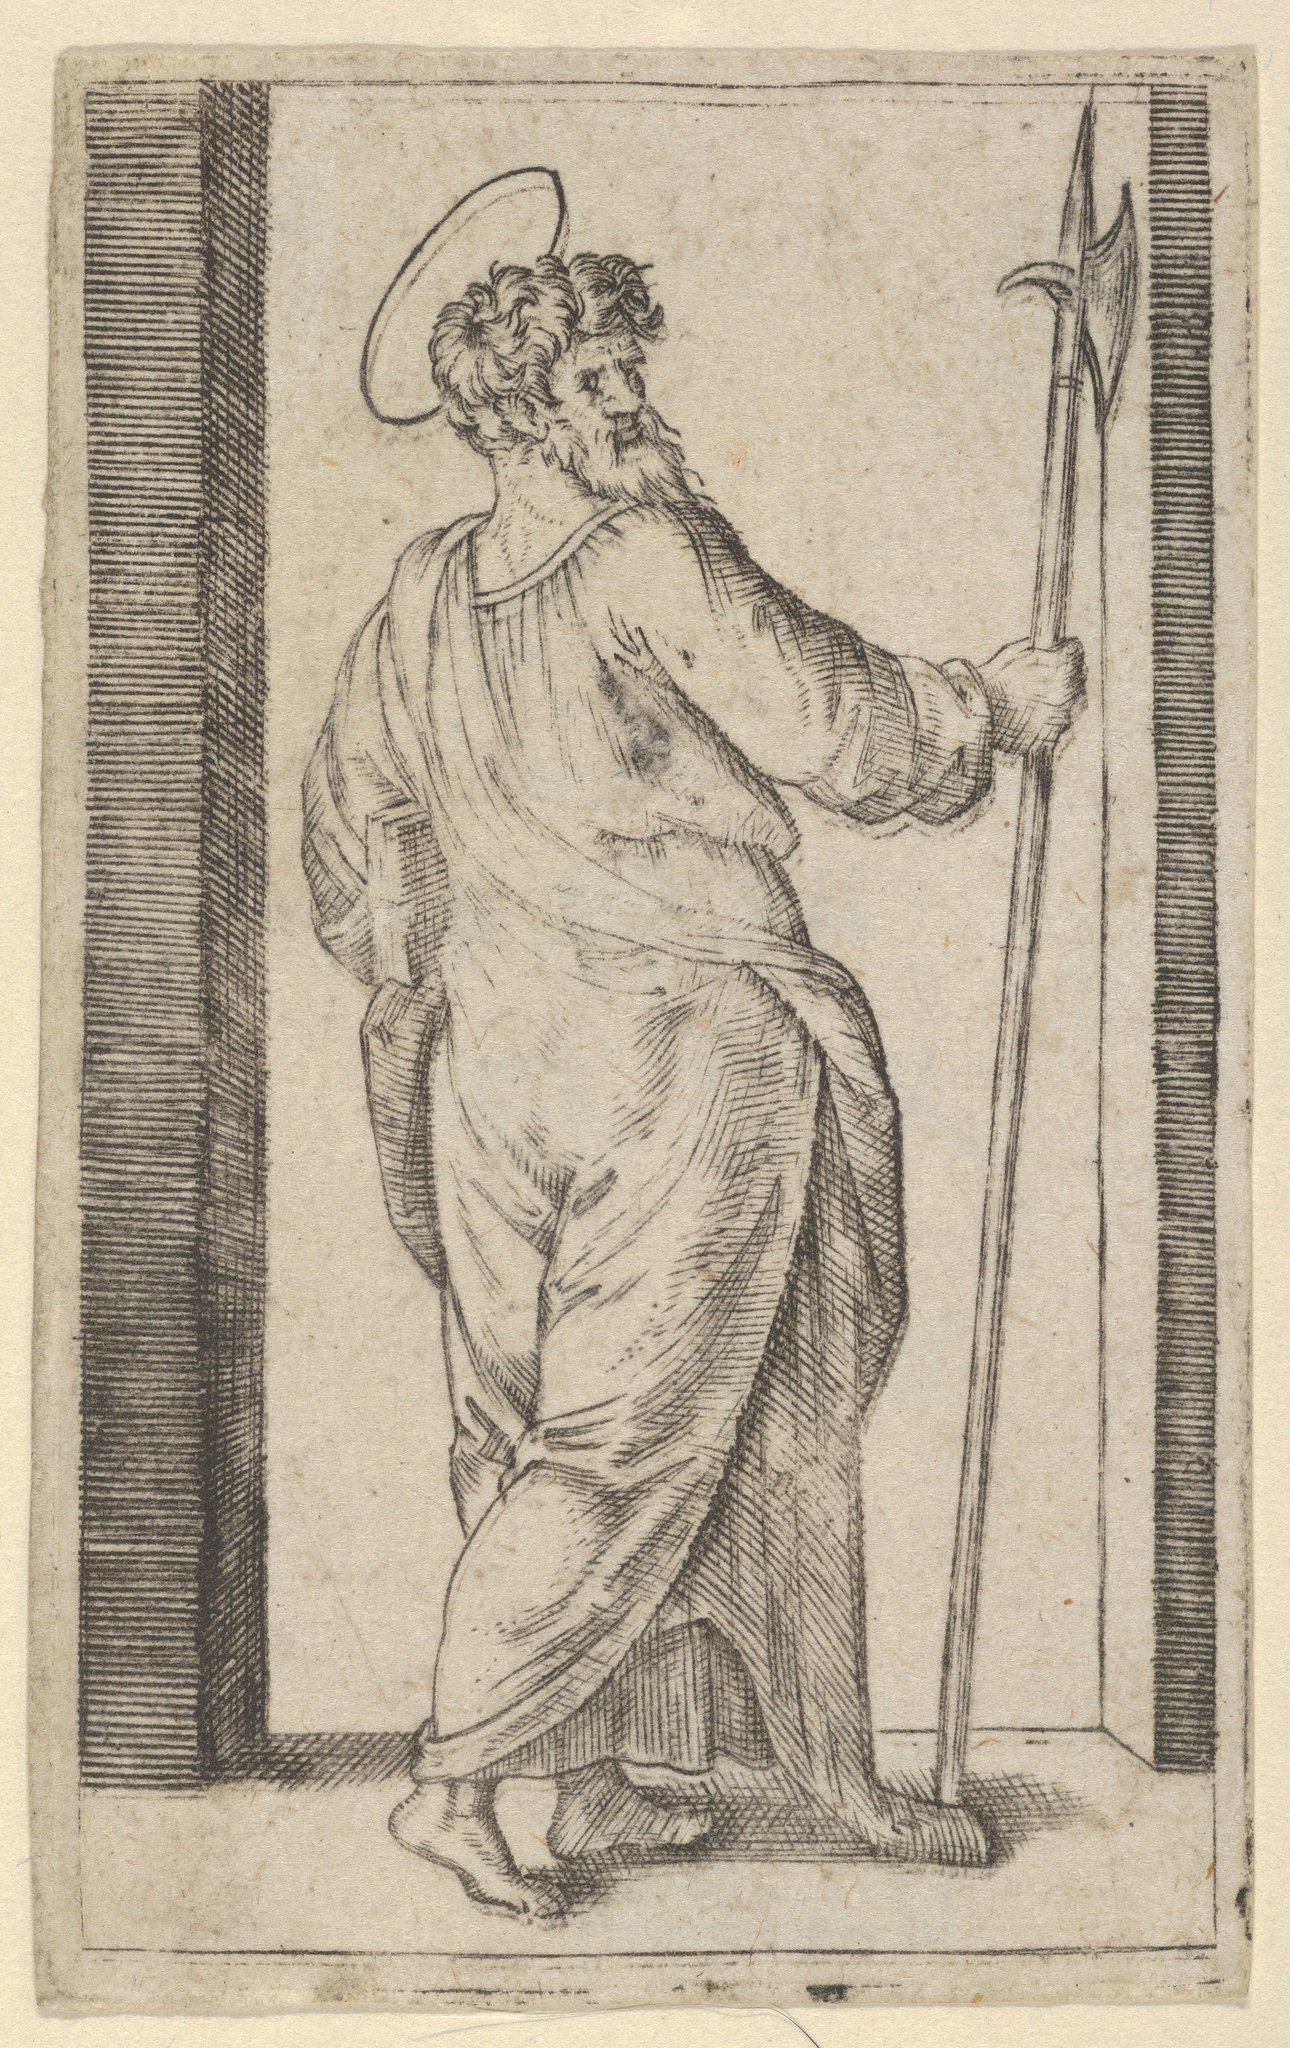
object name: print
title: Saint Jude, holding a halberd in his right hand, from "Piccoli Santi" (Small Saints)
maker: marcantonio raimondi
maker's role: artist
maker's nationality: italian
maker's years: 1475-1534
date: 1500-1527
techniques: engraving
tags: weapons,saints